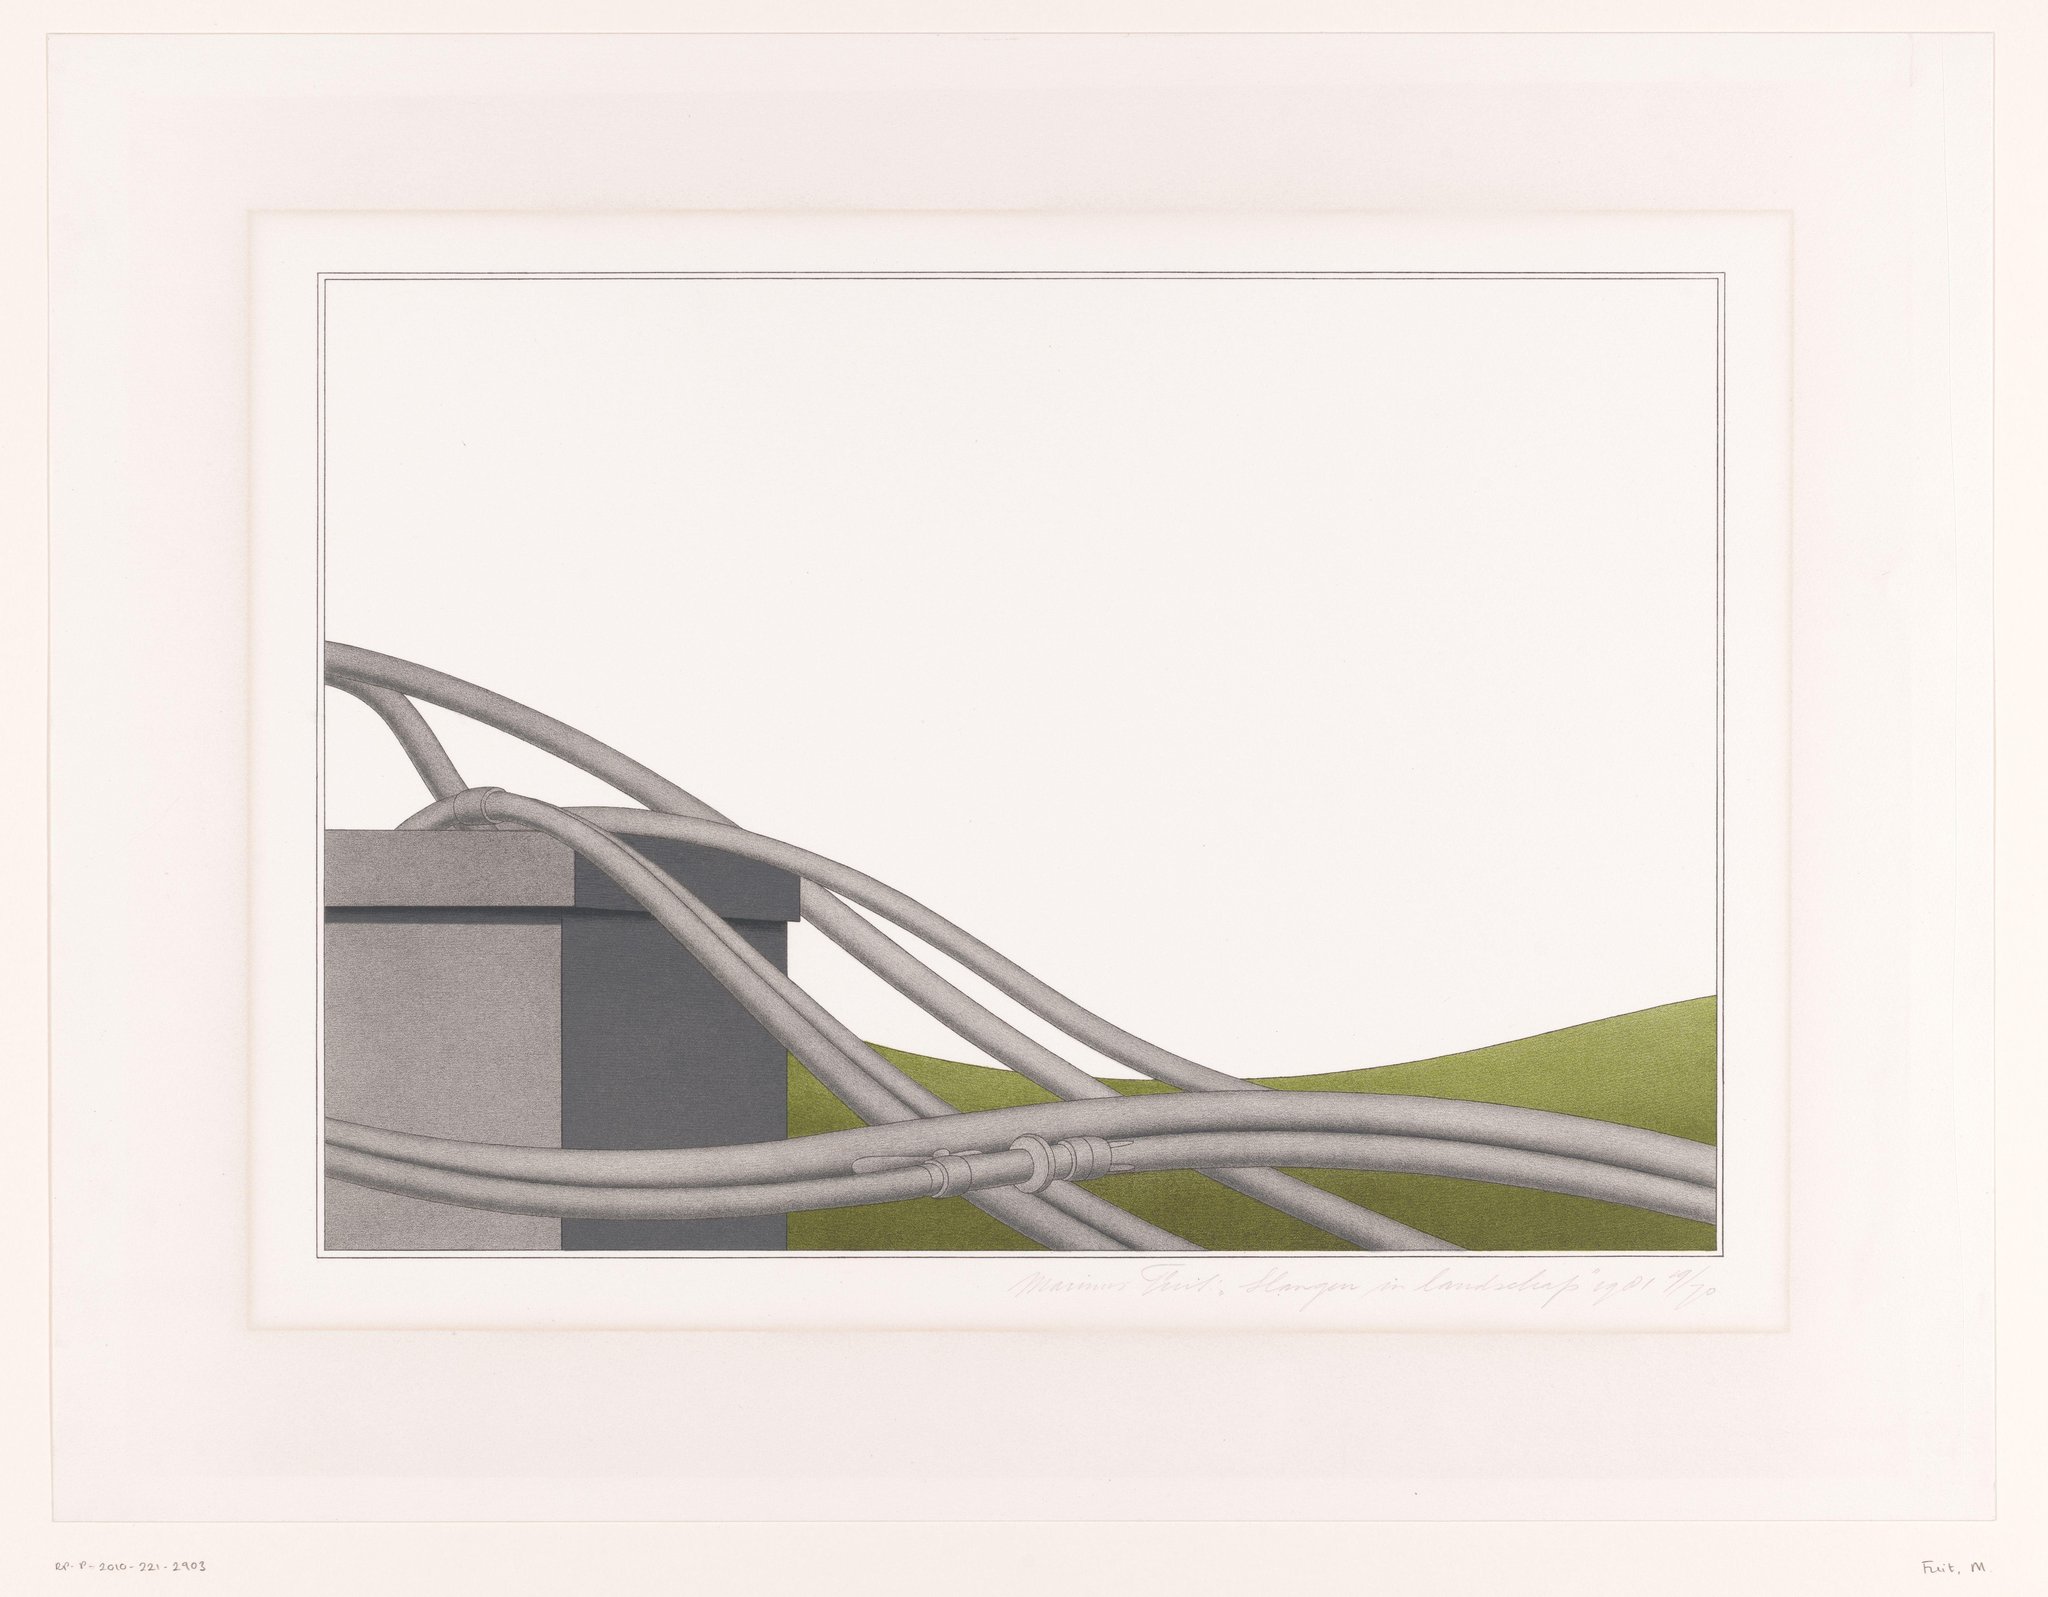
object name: print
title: Slangen in landschap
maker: marinus fuit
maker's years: 1934-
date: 1981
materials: paper, ink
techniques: lithograph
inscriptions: signature, date and inscription: ‘Marinus Fuit: "Slangen in landschap" 1981 19/70’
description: Kabels bij een muur met op de achtergrond een groen veld.